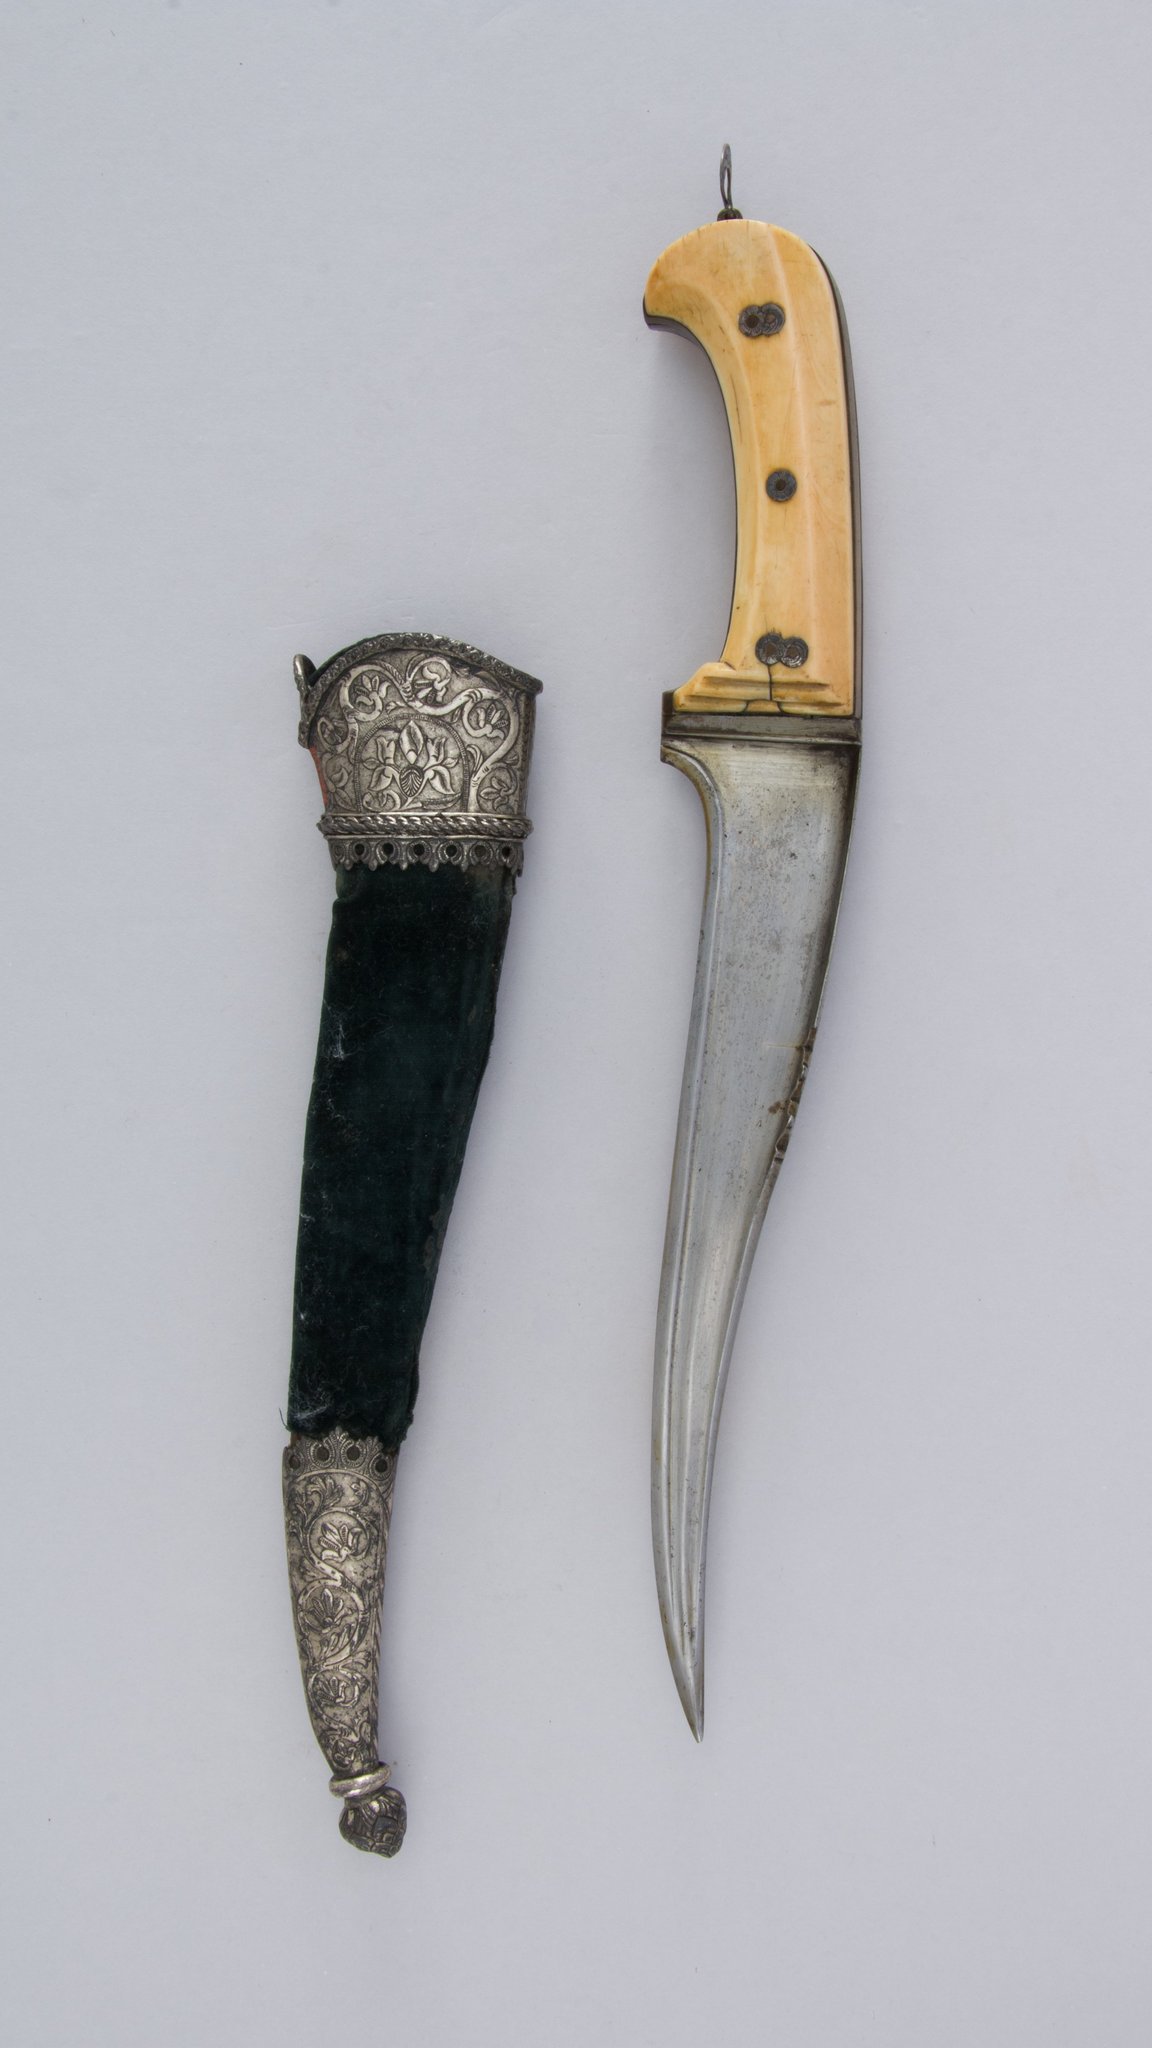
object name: dagger pesh kabz with sheath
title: Dagger (Pesh-kabz) with Sheath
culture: afghan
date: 1701-1900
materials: brass, gold, ivory, silver, steel, velvet, wood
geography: afghanistan